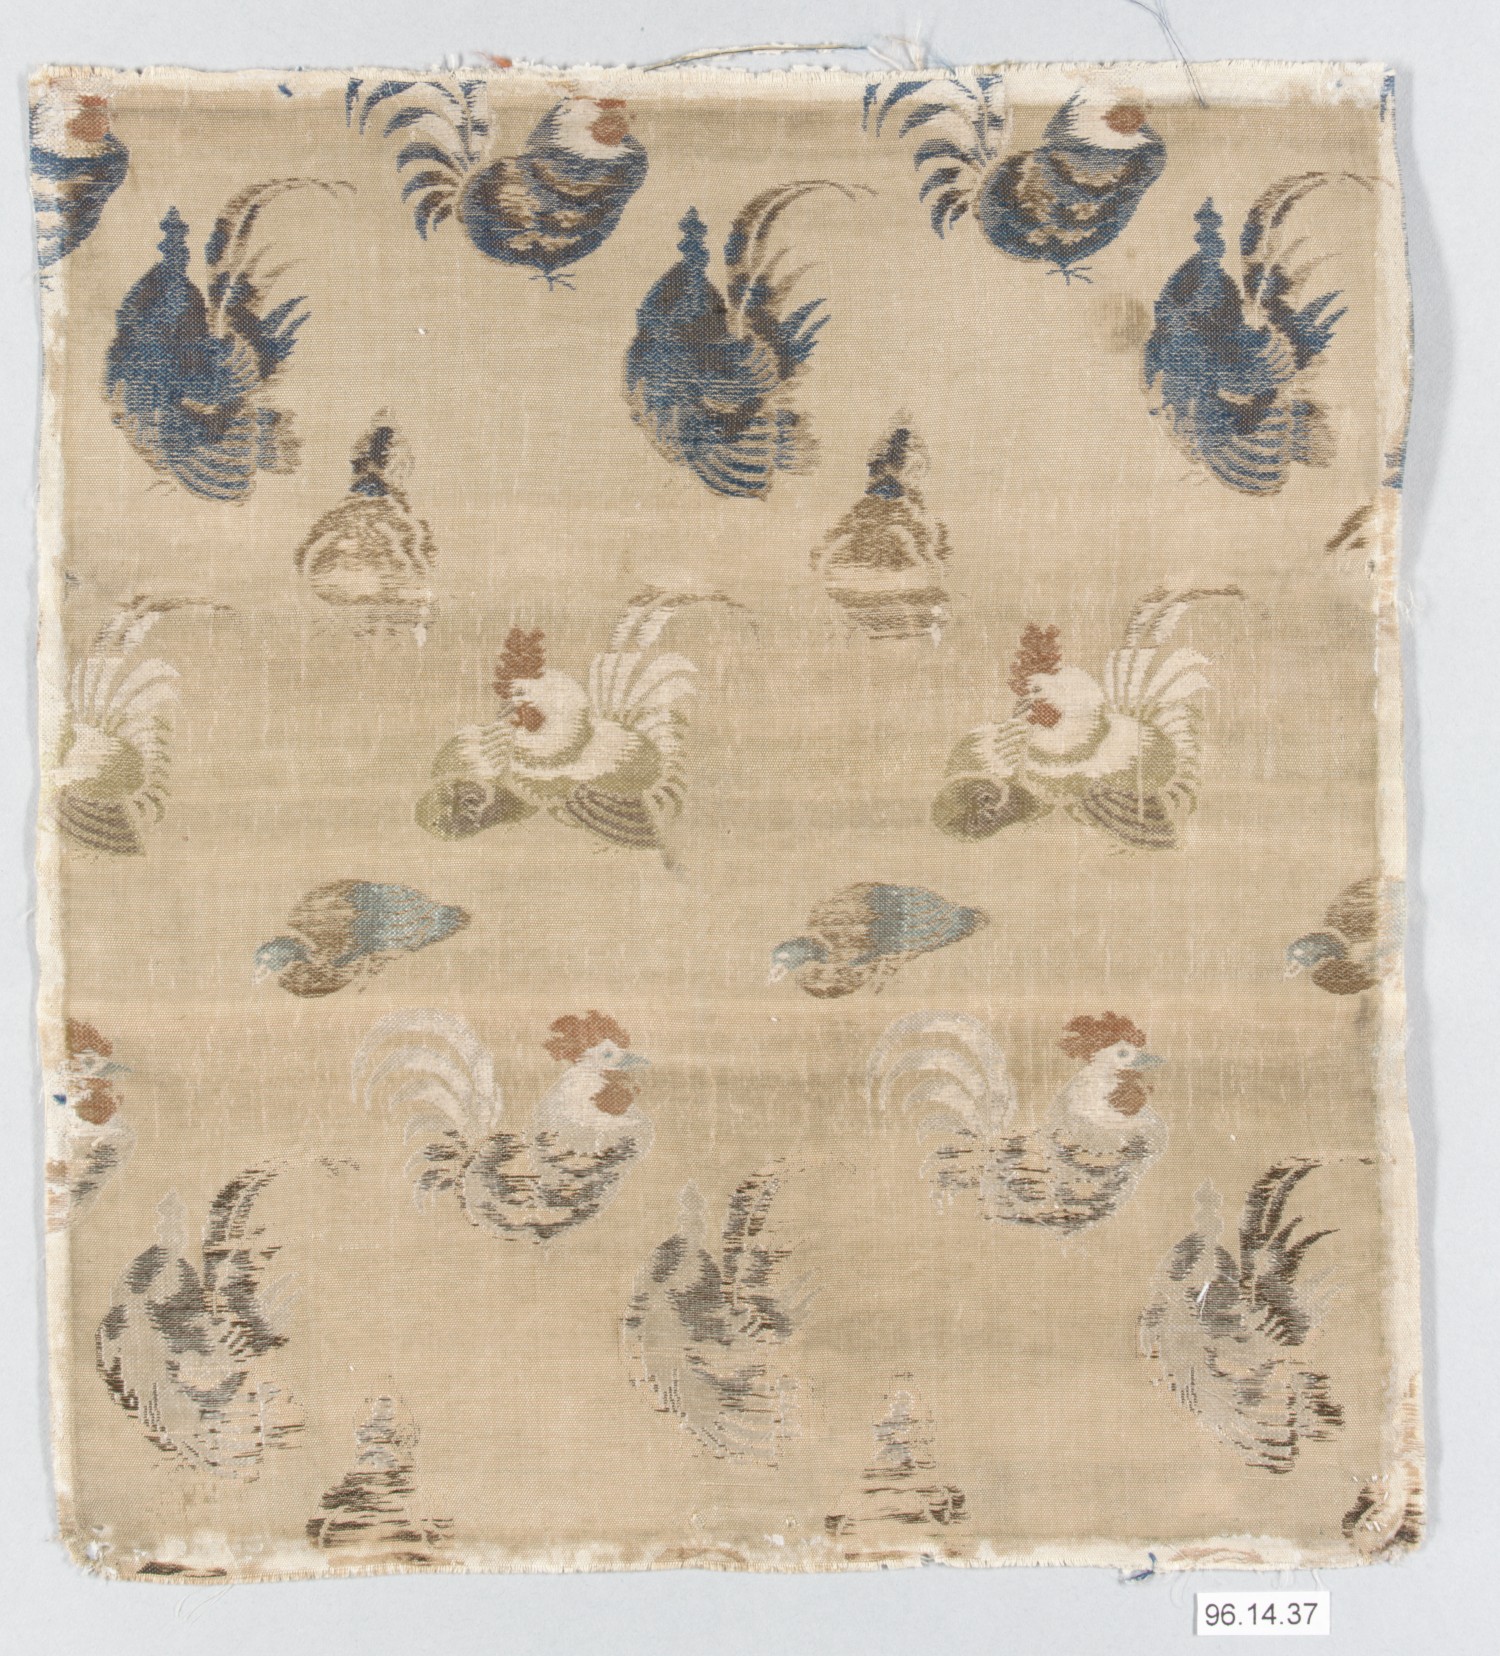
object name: piece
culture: japanese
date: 1801-1833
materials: metal thread, silk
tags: ducks,roosters